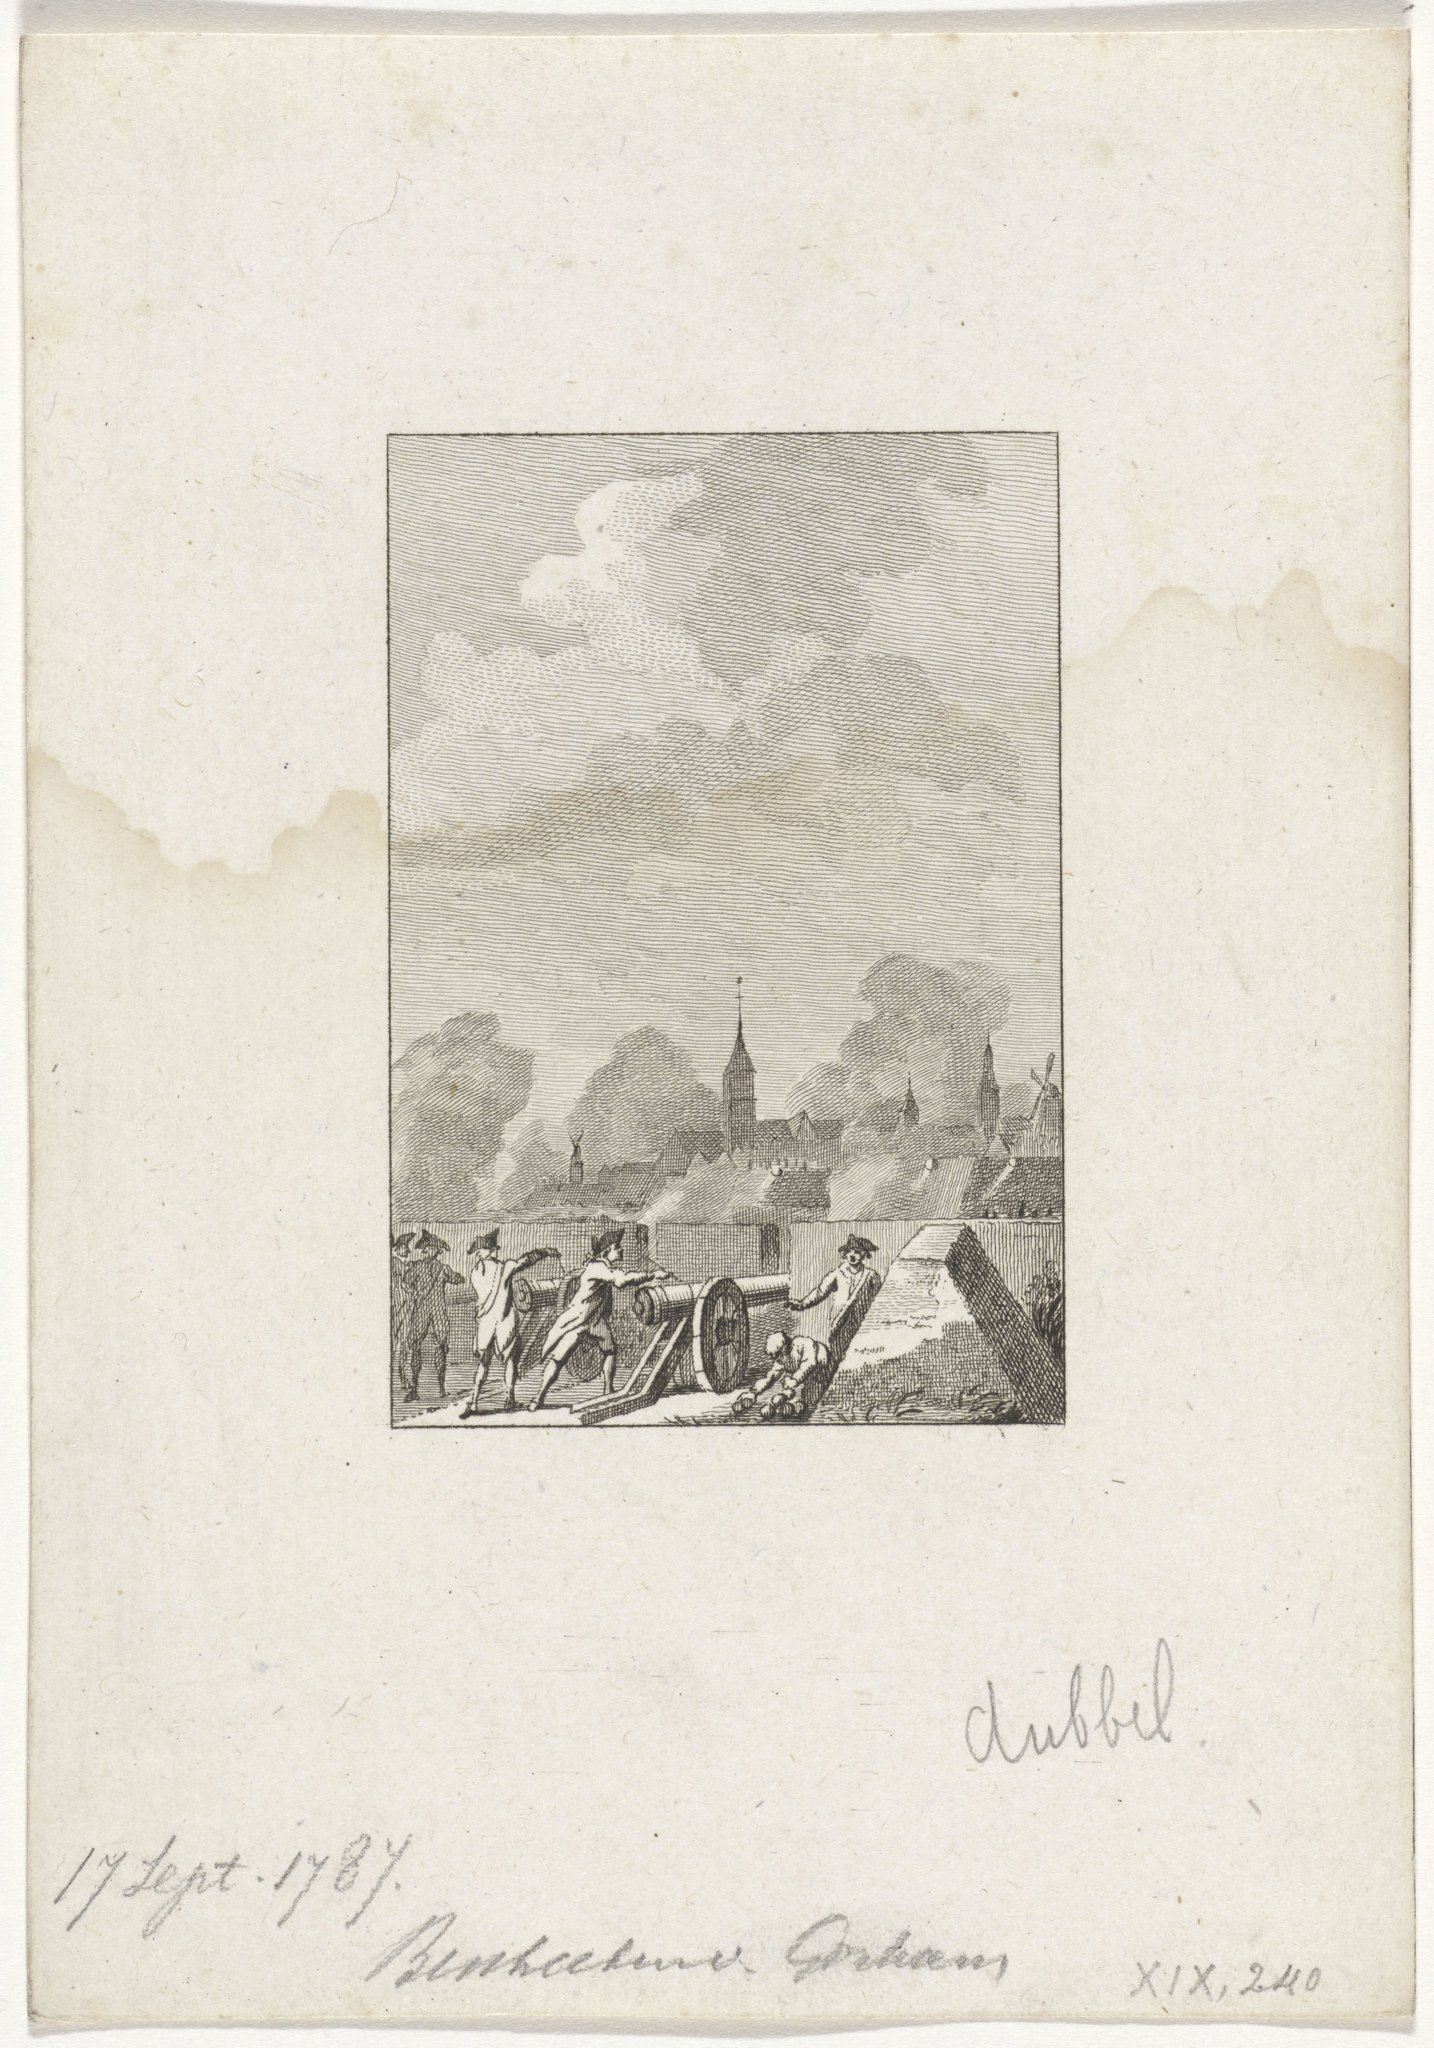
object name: history print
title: Pruisen beschieten Gorinchem, 1787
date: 1783-1795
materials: paper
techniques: etching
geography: amsterdam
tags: siege, position war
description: Illustratie voor: J. Fokke. Geschiedenissen der Vereenigde Nederlanden voor de vaderlandsche jeugd. Amsterdam: Johannes Allart, 1783-1795, 25 delen. deel XIX pl. IX.